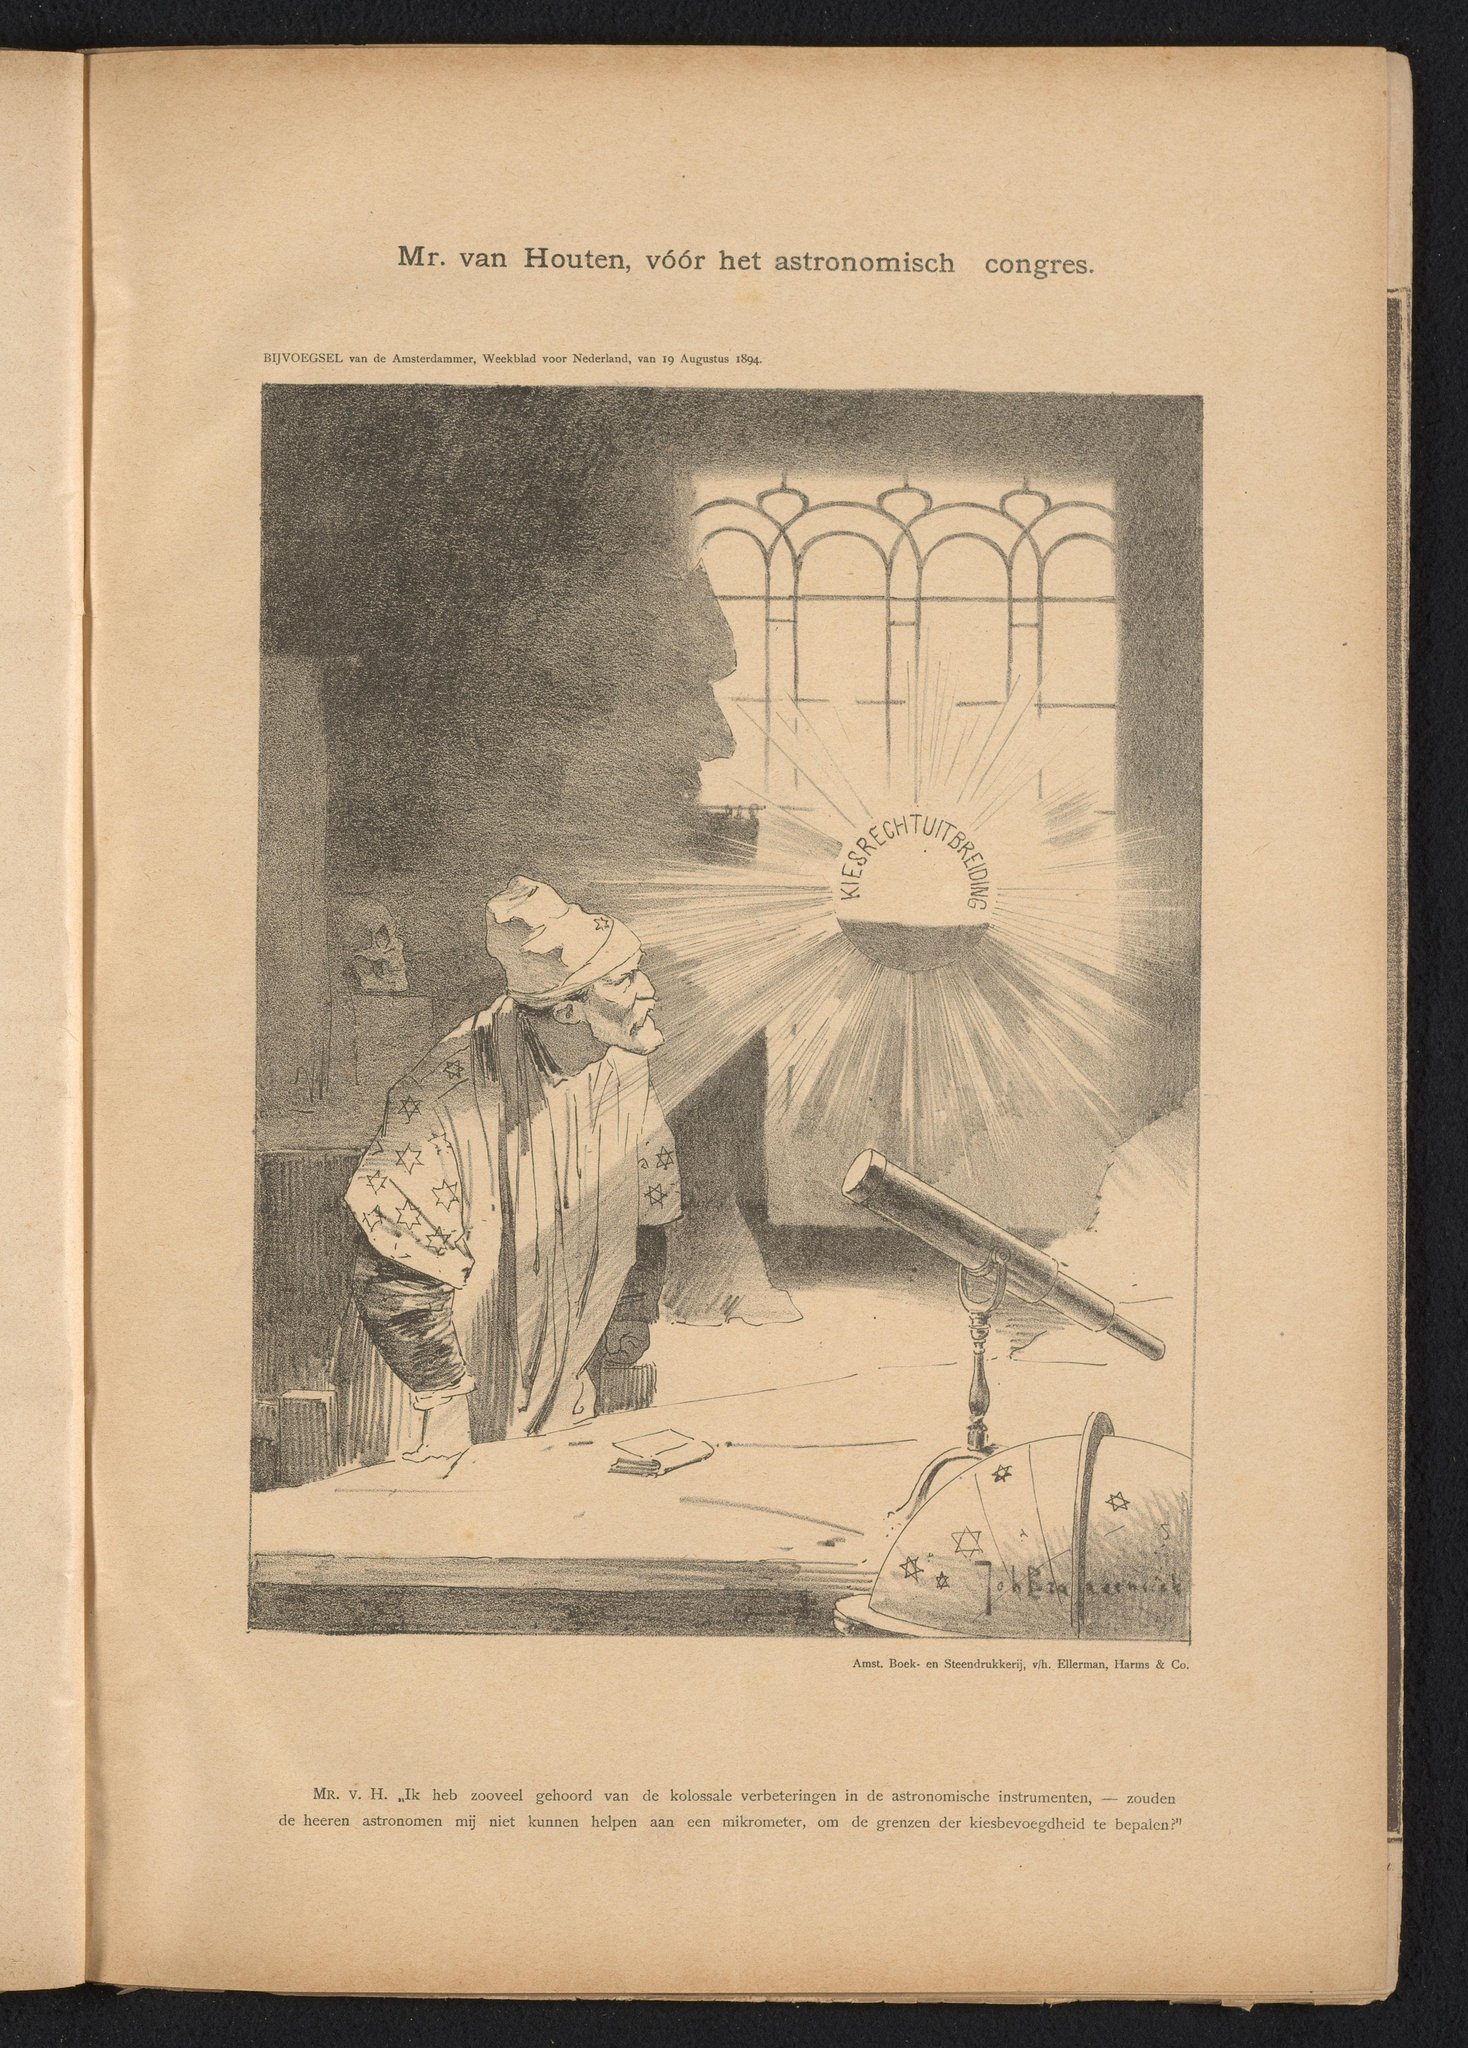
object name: cartoon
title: Mr. van Houten, vóór het astronomisch congres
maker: johan braakensiek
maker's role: draughtsman, print maker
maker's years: 1858-1940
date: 1894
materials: paper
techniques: lithograph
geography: amsterdam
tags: the hague, samuel van houten, scholar in his study, the right to vote, the compulsory vote, sorcerer, magician, wizard, warlock, political caricatures and satires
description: Minister van Binnenlandse Zaken Samuel van Houten als de geleerde die in zijn werkkamer een geheimzinnig symbool 'kiesrechtuitbreiding' bestudeert. Naar de prent van Rembrandt.